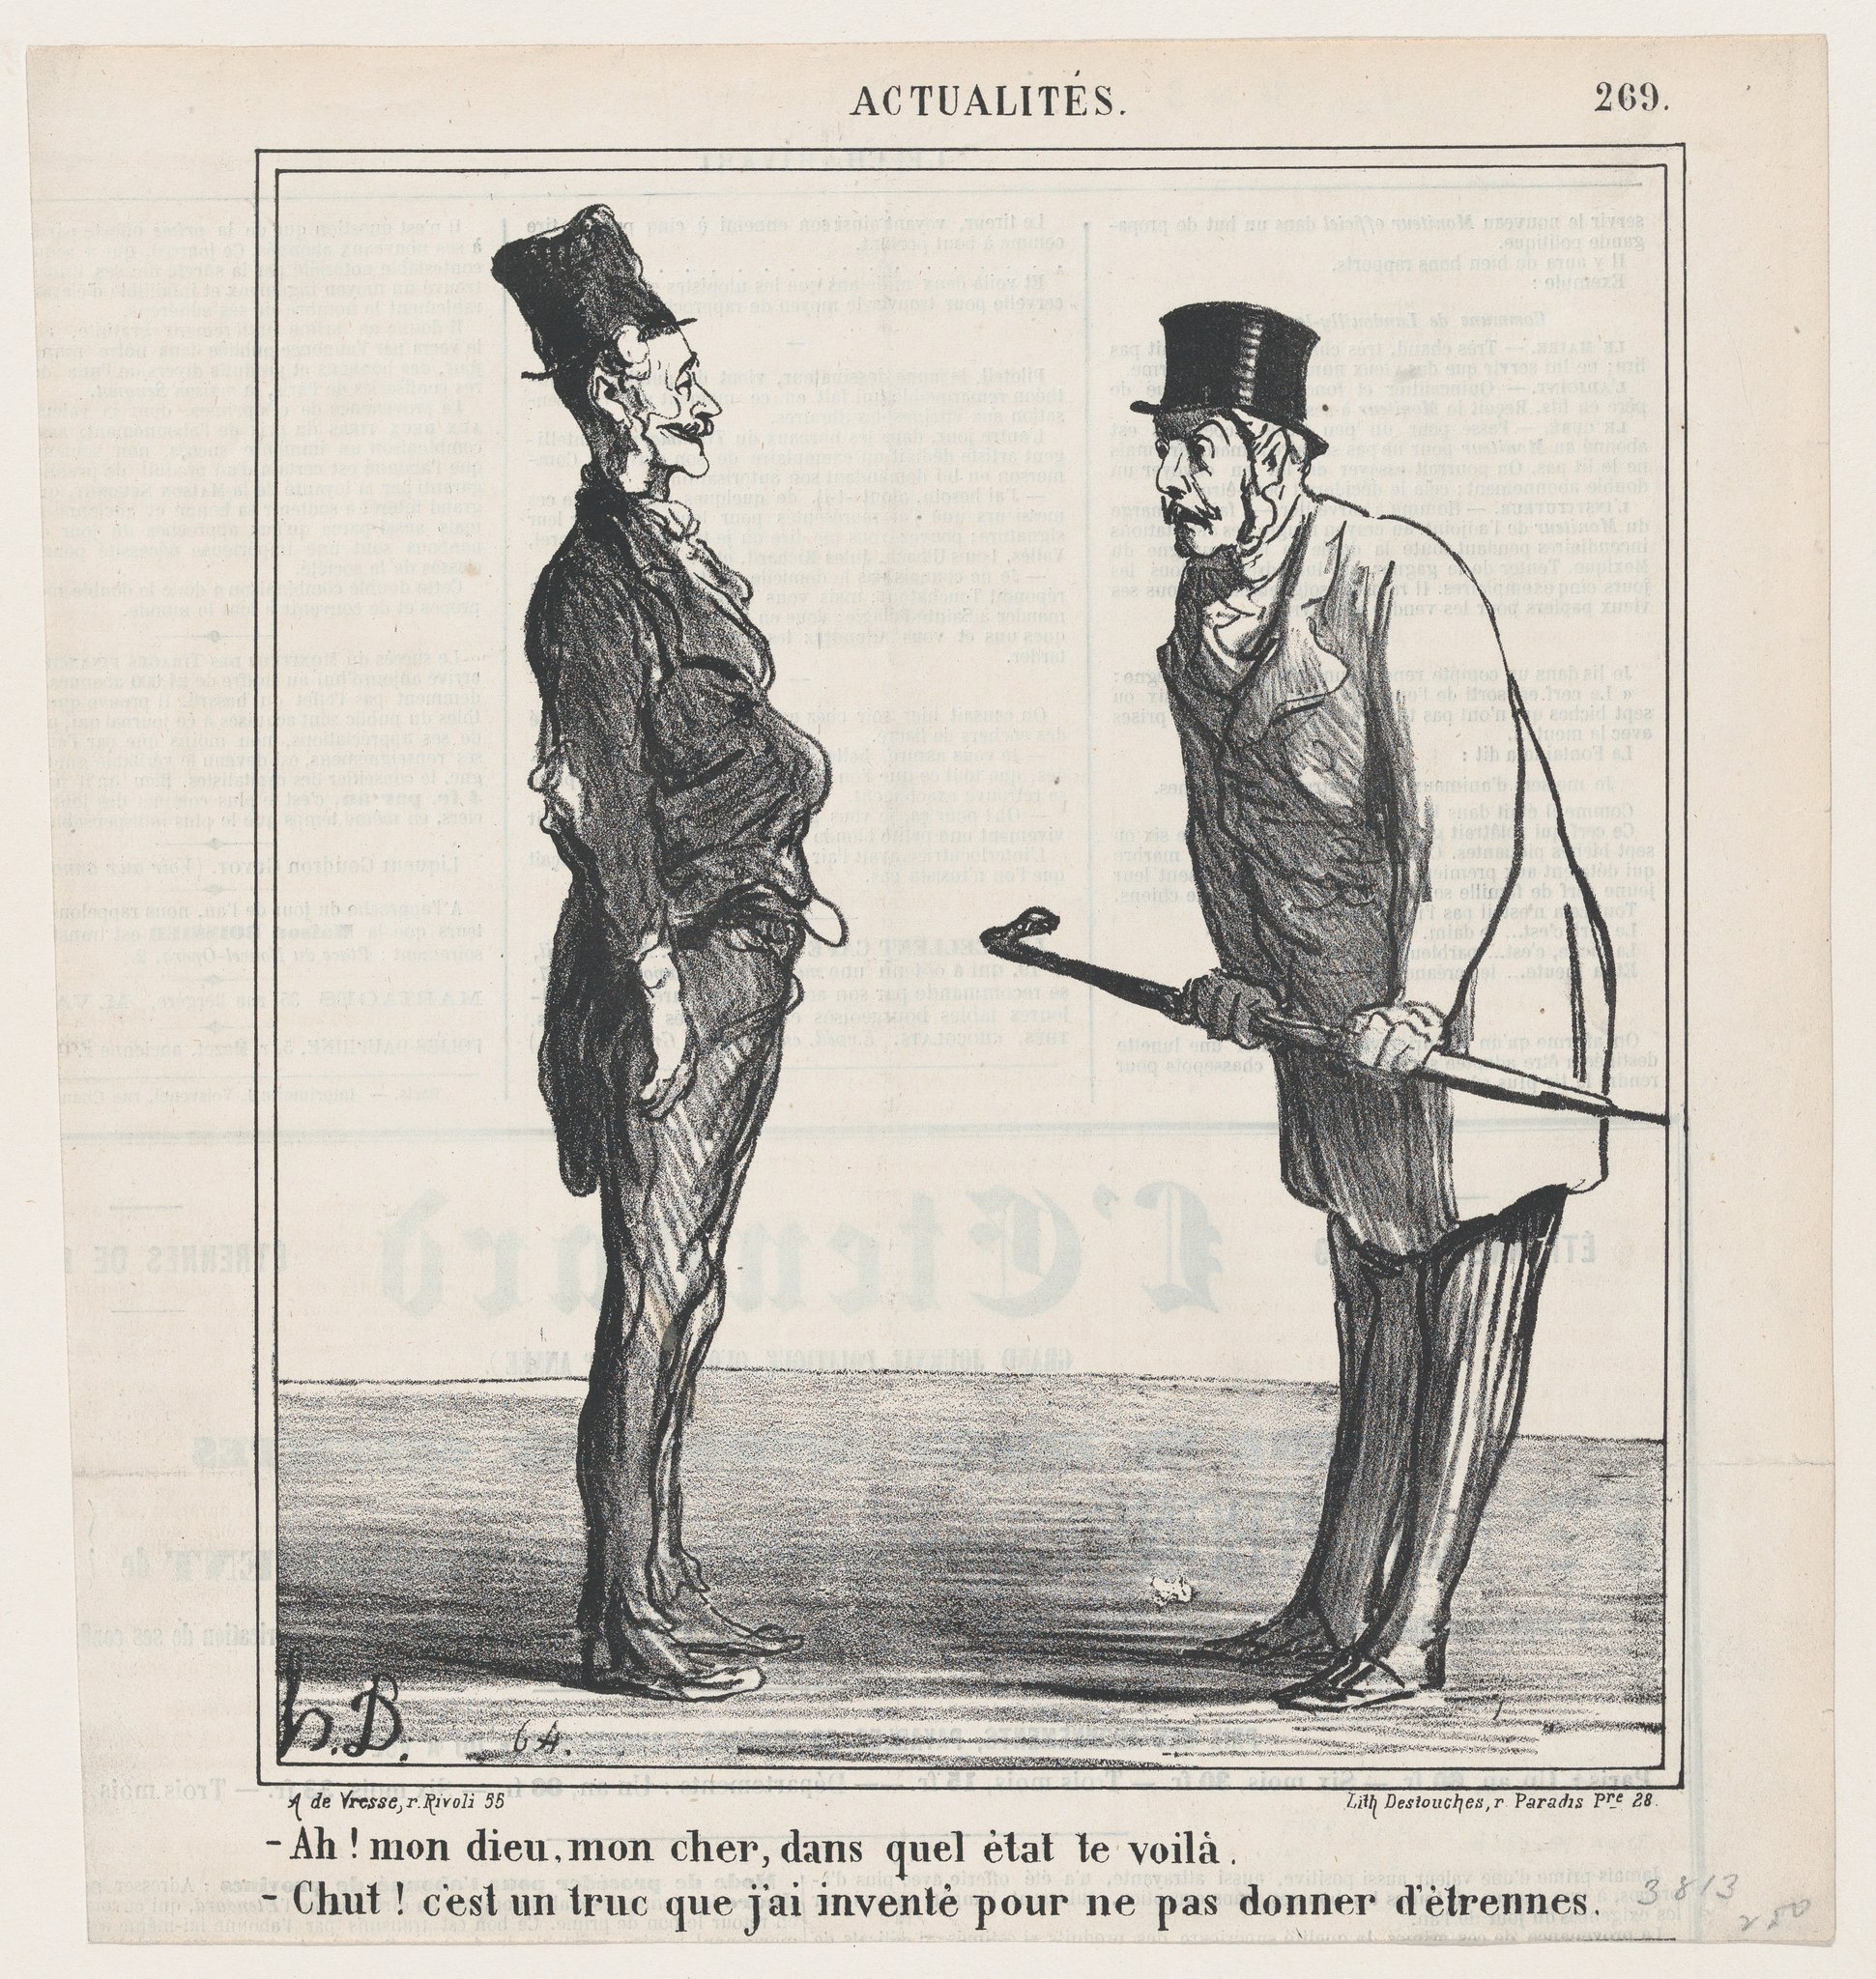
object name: print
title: – Good Lord, what has happened to you? – Hush! It's a trick I invented in order to avoid giving New Year's presents, from "News of the day"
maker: honoré daumier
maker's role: artist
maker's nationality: french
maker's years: 1808-1879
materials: paper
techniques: lithograph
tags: satire,men